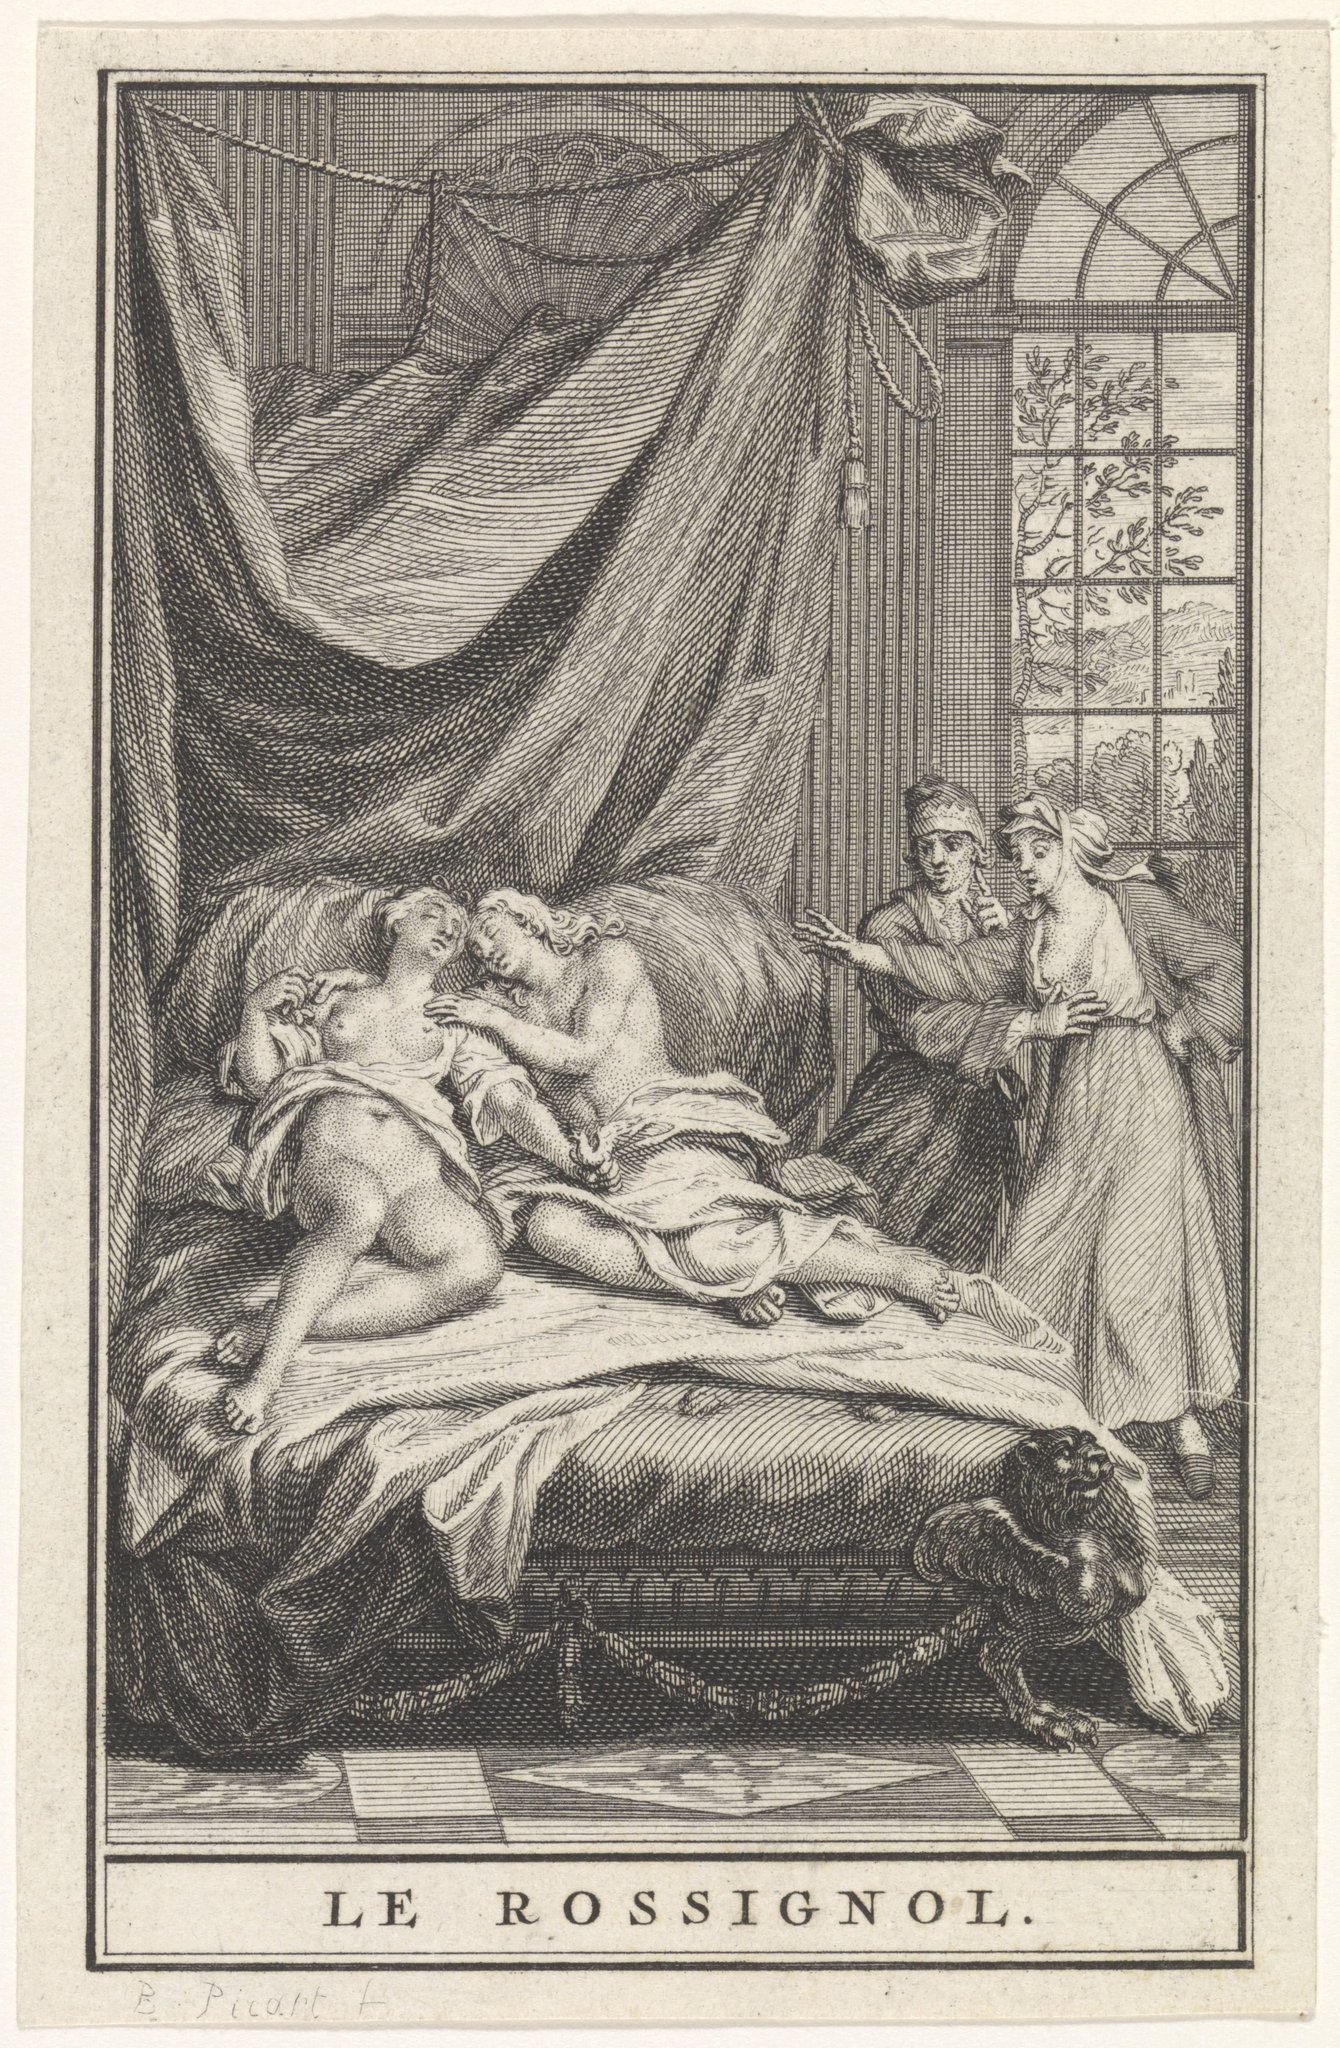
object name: book illustration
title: Jong paar betrapt door ouders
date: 1683-1733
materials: paper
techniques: engraving, etching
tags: song-birds: nightingale, hidden love discovered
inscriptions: collector's mark: Lugt 2228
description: Een jong paar in bed wordt betrapt door woedende ouders. De jonge vrouw houdt een nachtegaal in de hand. De vader steekt vermanend zijn vinger op en moet zijn woedende vrouw tegenhouden.